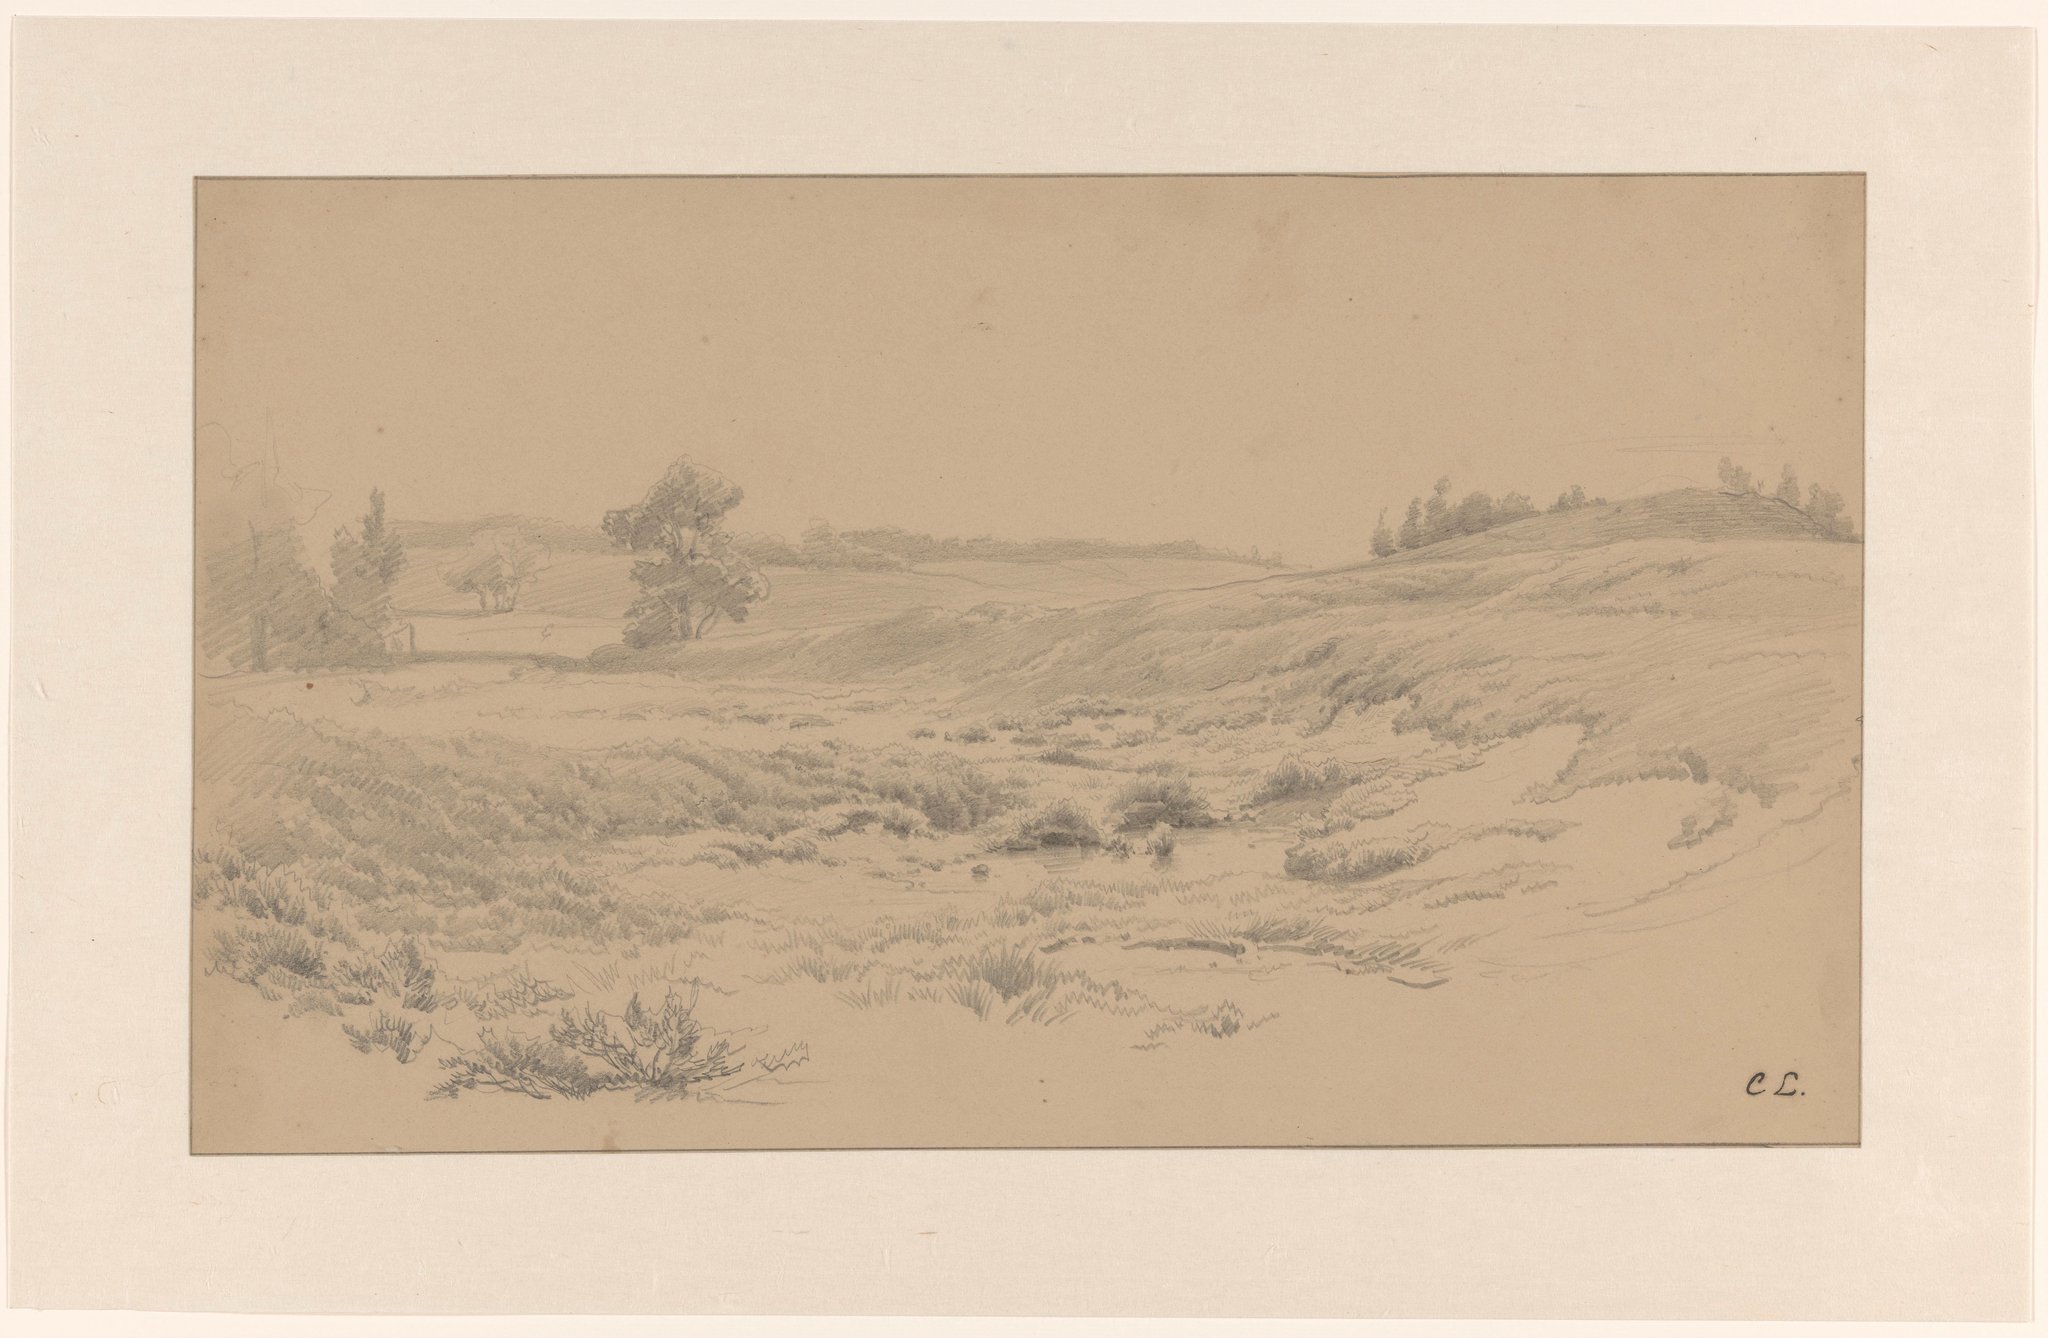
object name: drawing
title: Heidelandschap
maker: cornelis lieste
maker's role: draughtsman, print maker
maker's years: 1817-1861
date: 1827-1861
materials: paper, pencil